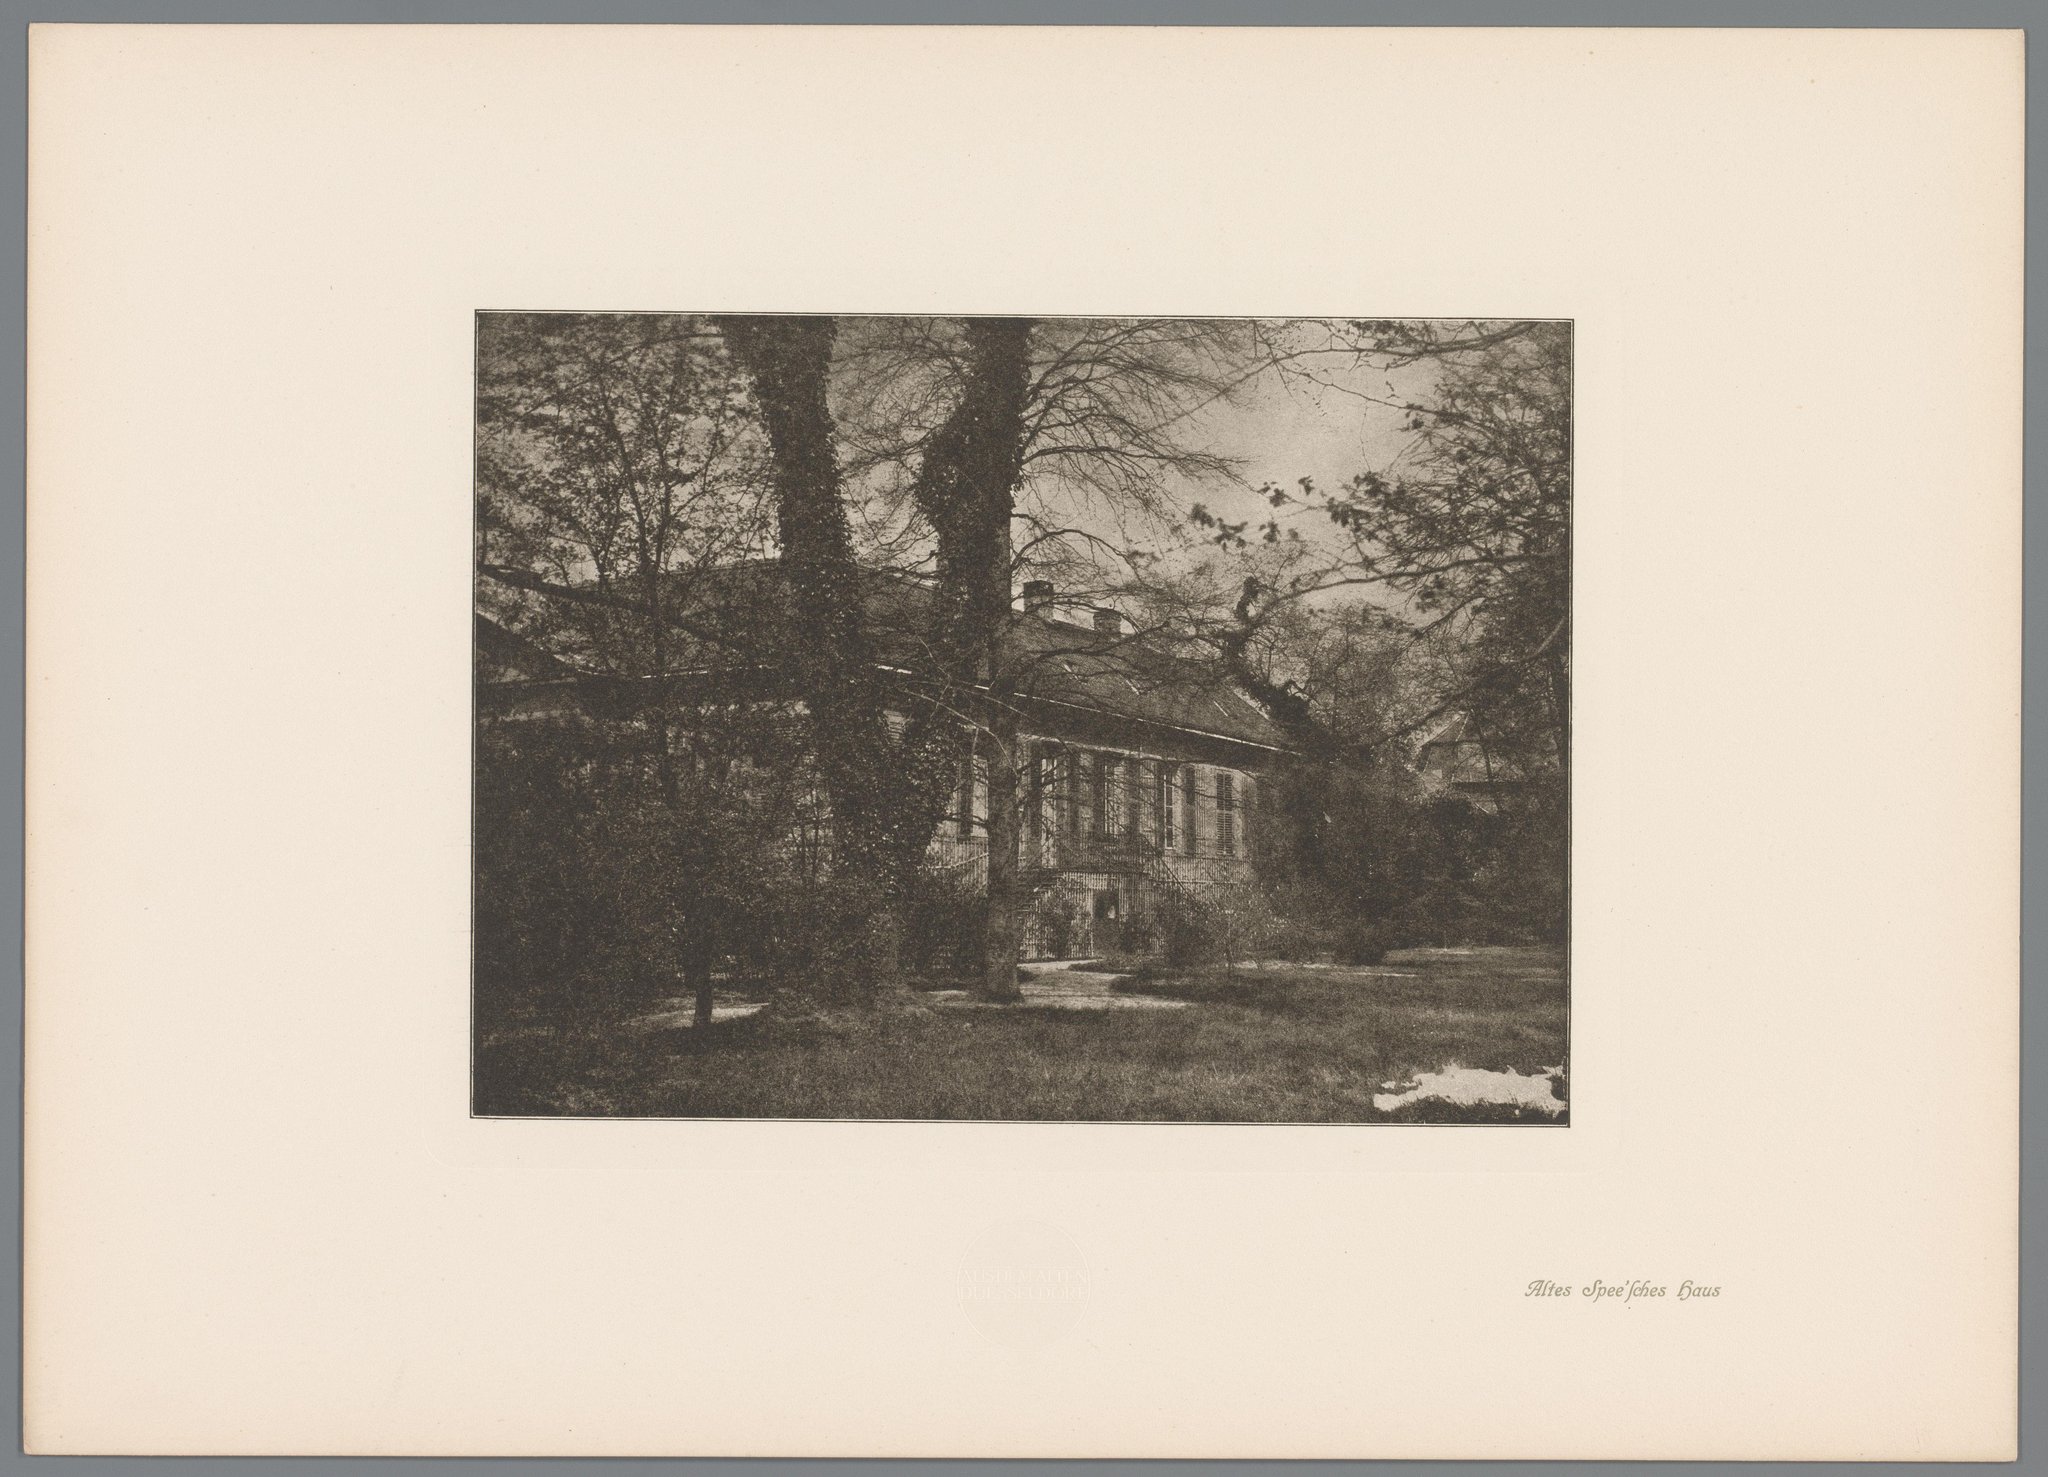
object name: reproduction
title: Reproductie van een gomdruk van het Palais Spee in de Spee’scher Graben in Düsseldorf door Erwin Quedenfeldt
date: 1902-1907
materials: paper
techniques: autotype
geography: offenbach am main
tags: palace